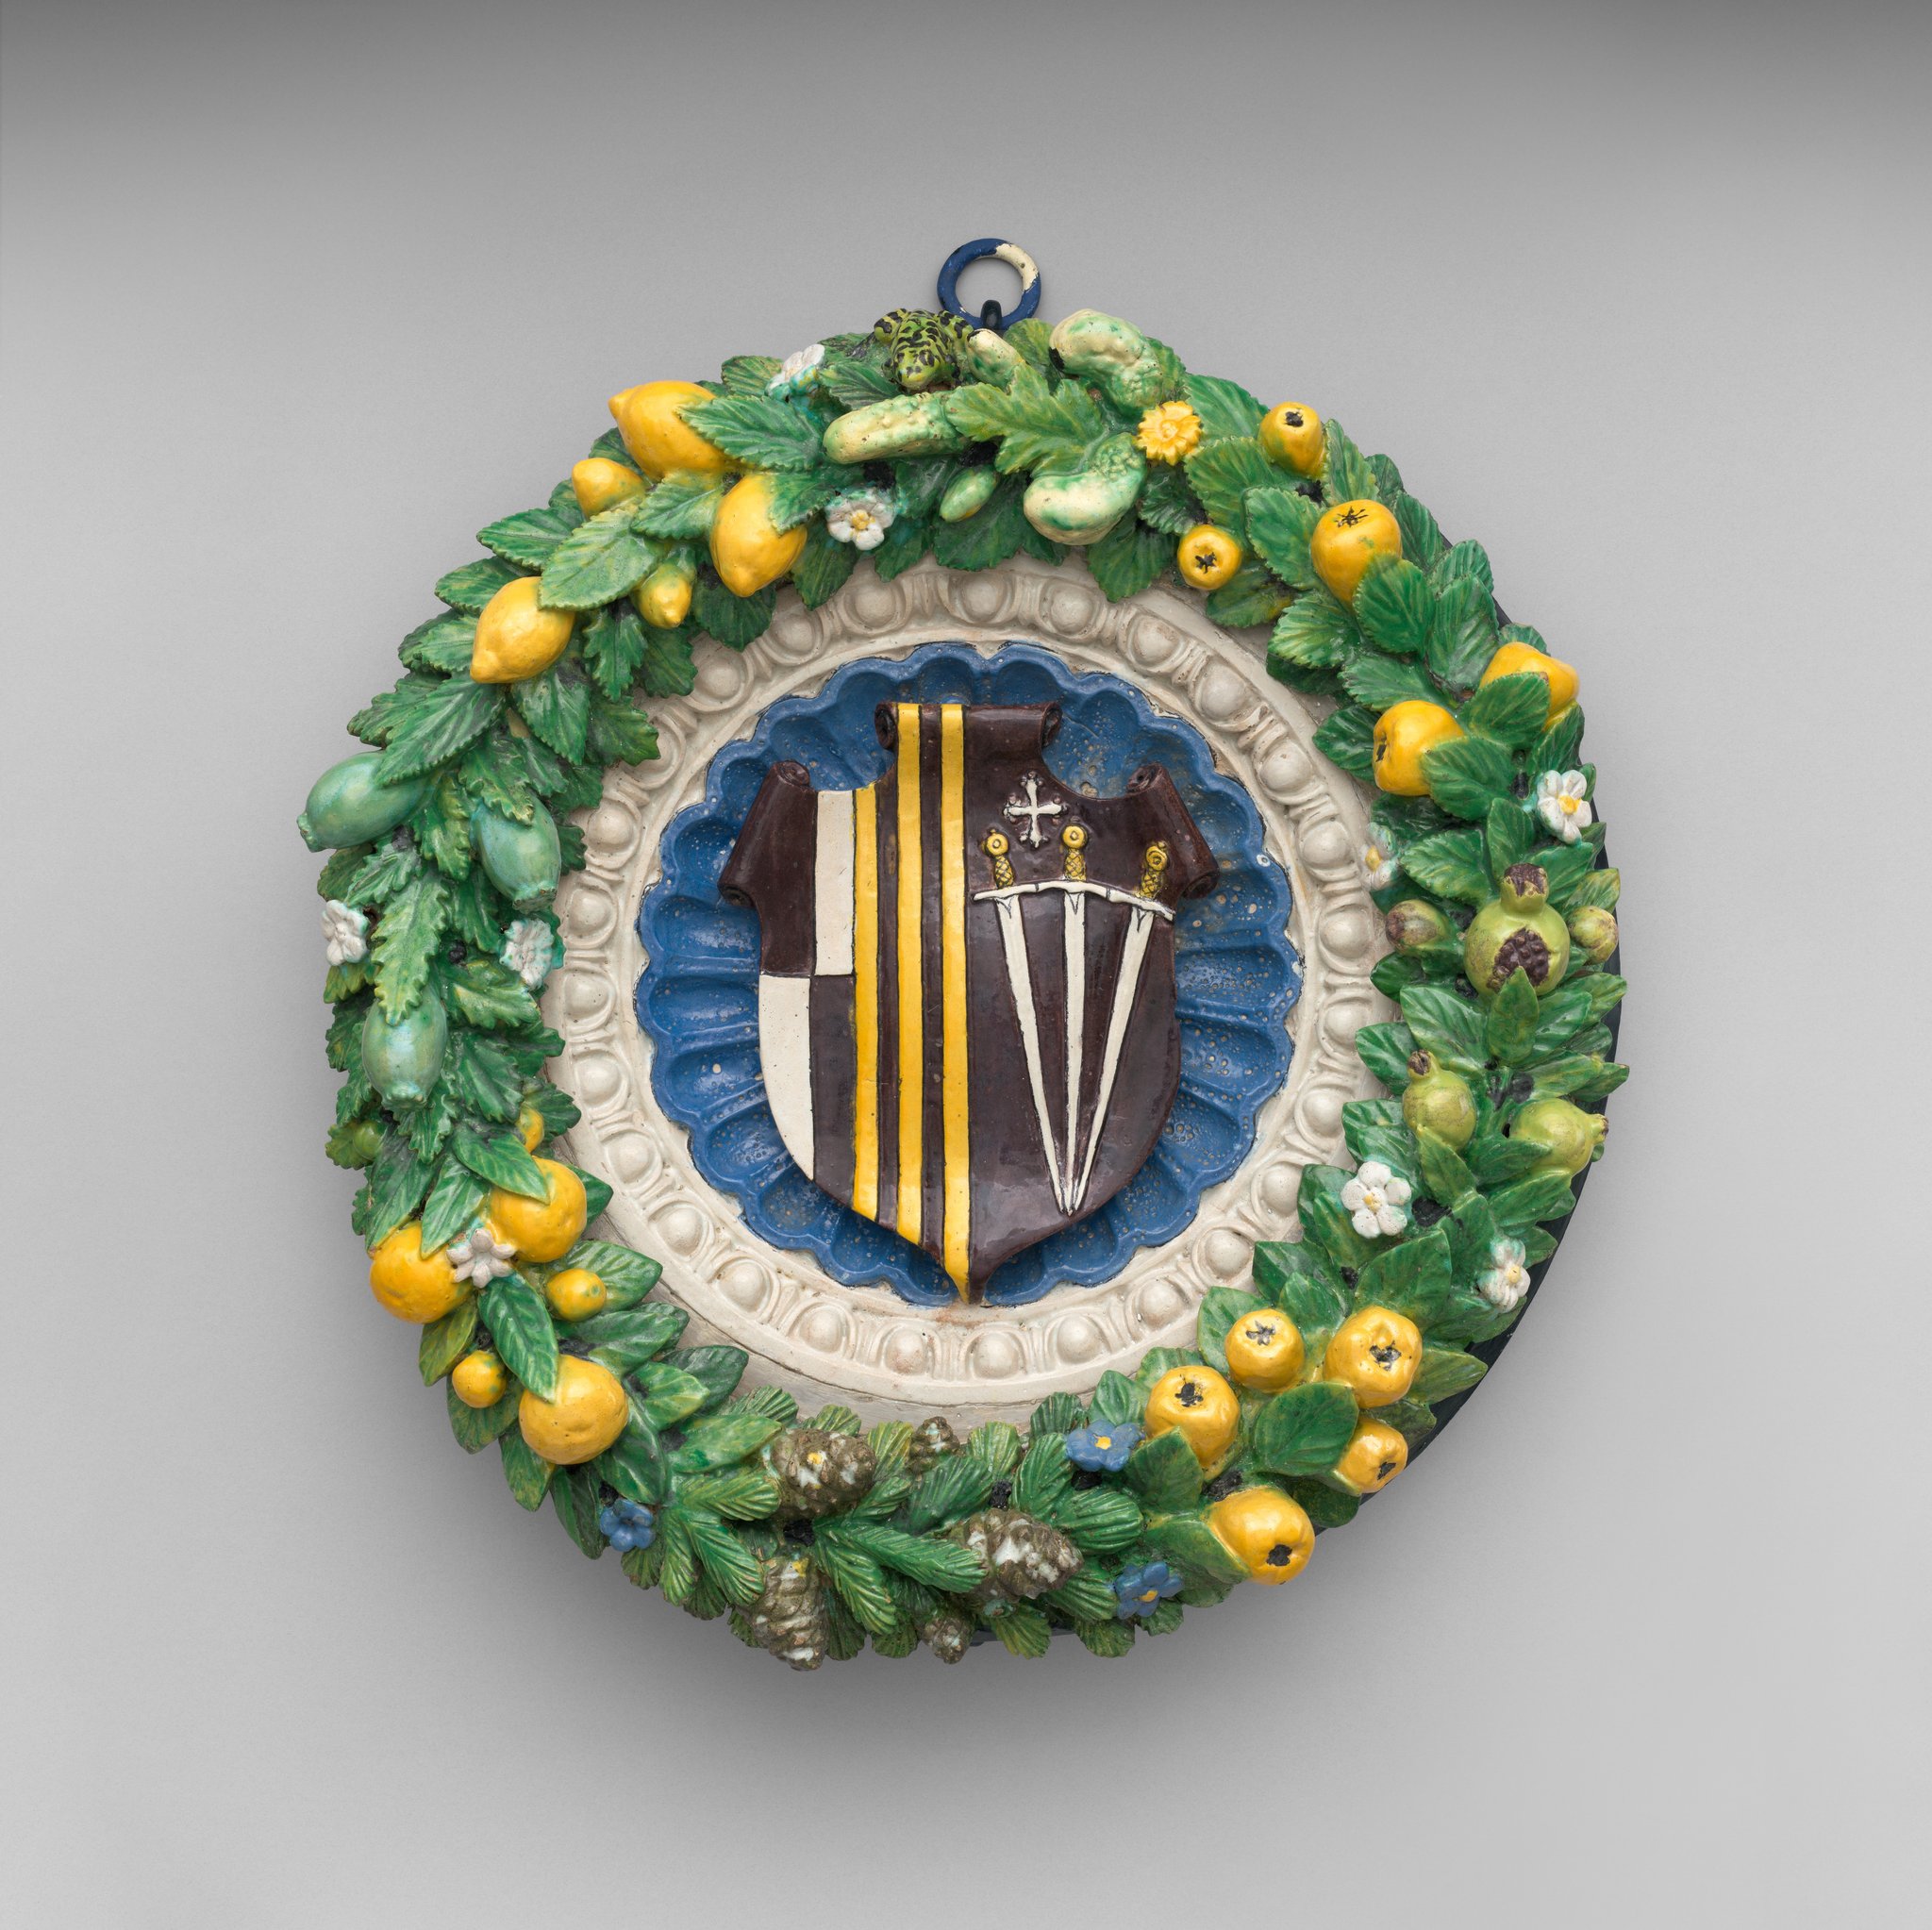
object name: tondo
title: Minerbetti coat of arms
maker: giovanni della robbia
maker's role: artist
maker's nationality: italian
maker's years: 1469-1530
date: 1510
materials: terracotta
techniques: glazing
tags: fruit,coat of arms